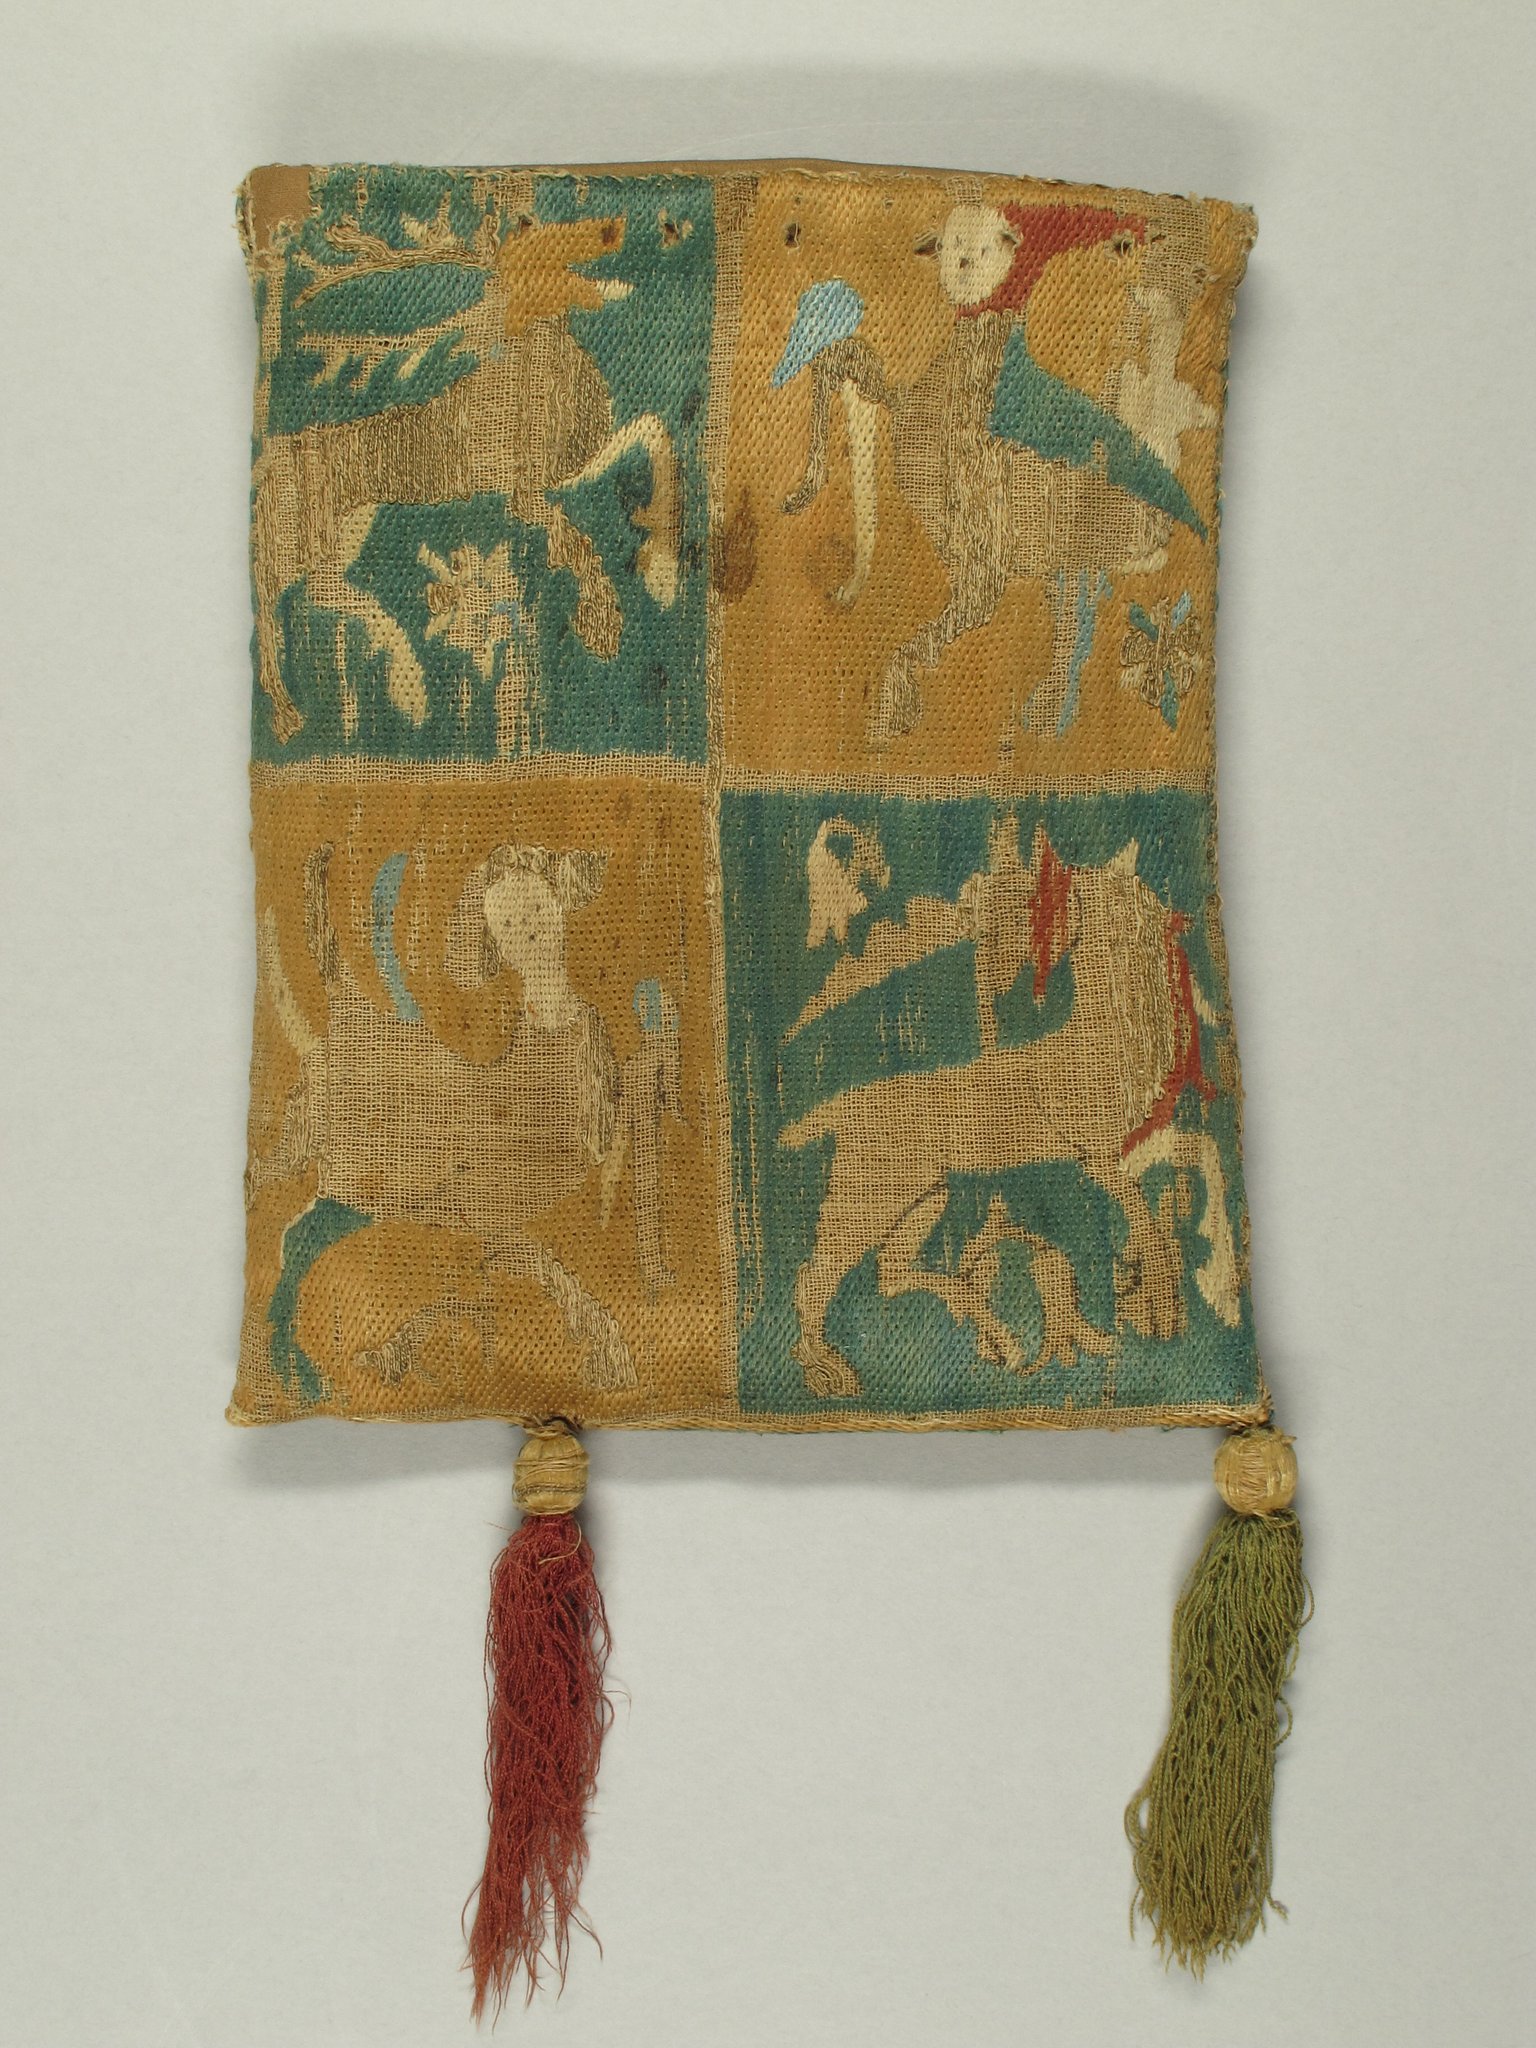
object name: purse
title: Purse with Two Figures under a Tree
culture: french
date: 1301-1400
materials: canvas, metal thread, silk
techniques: embroidery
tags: deer